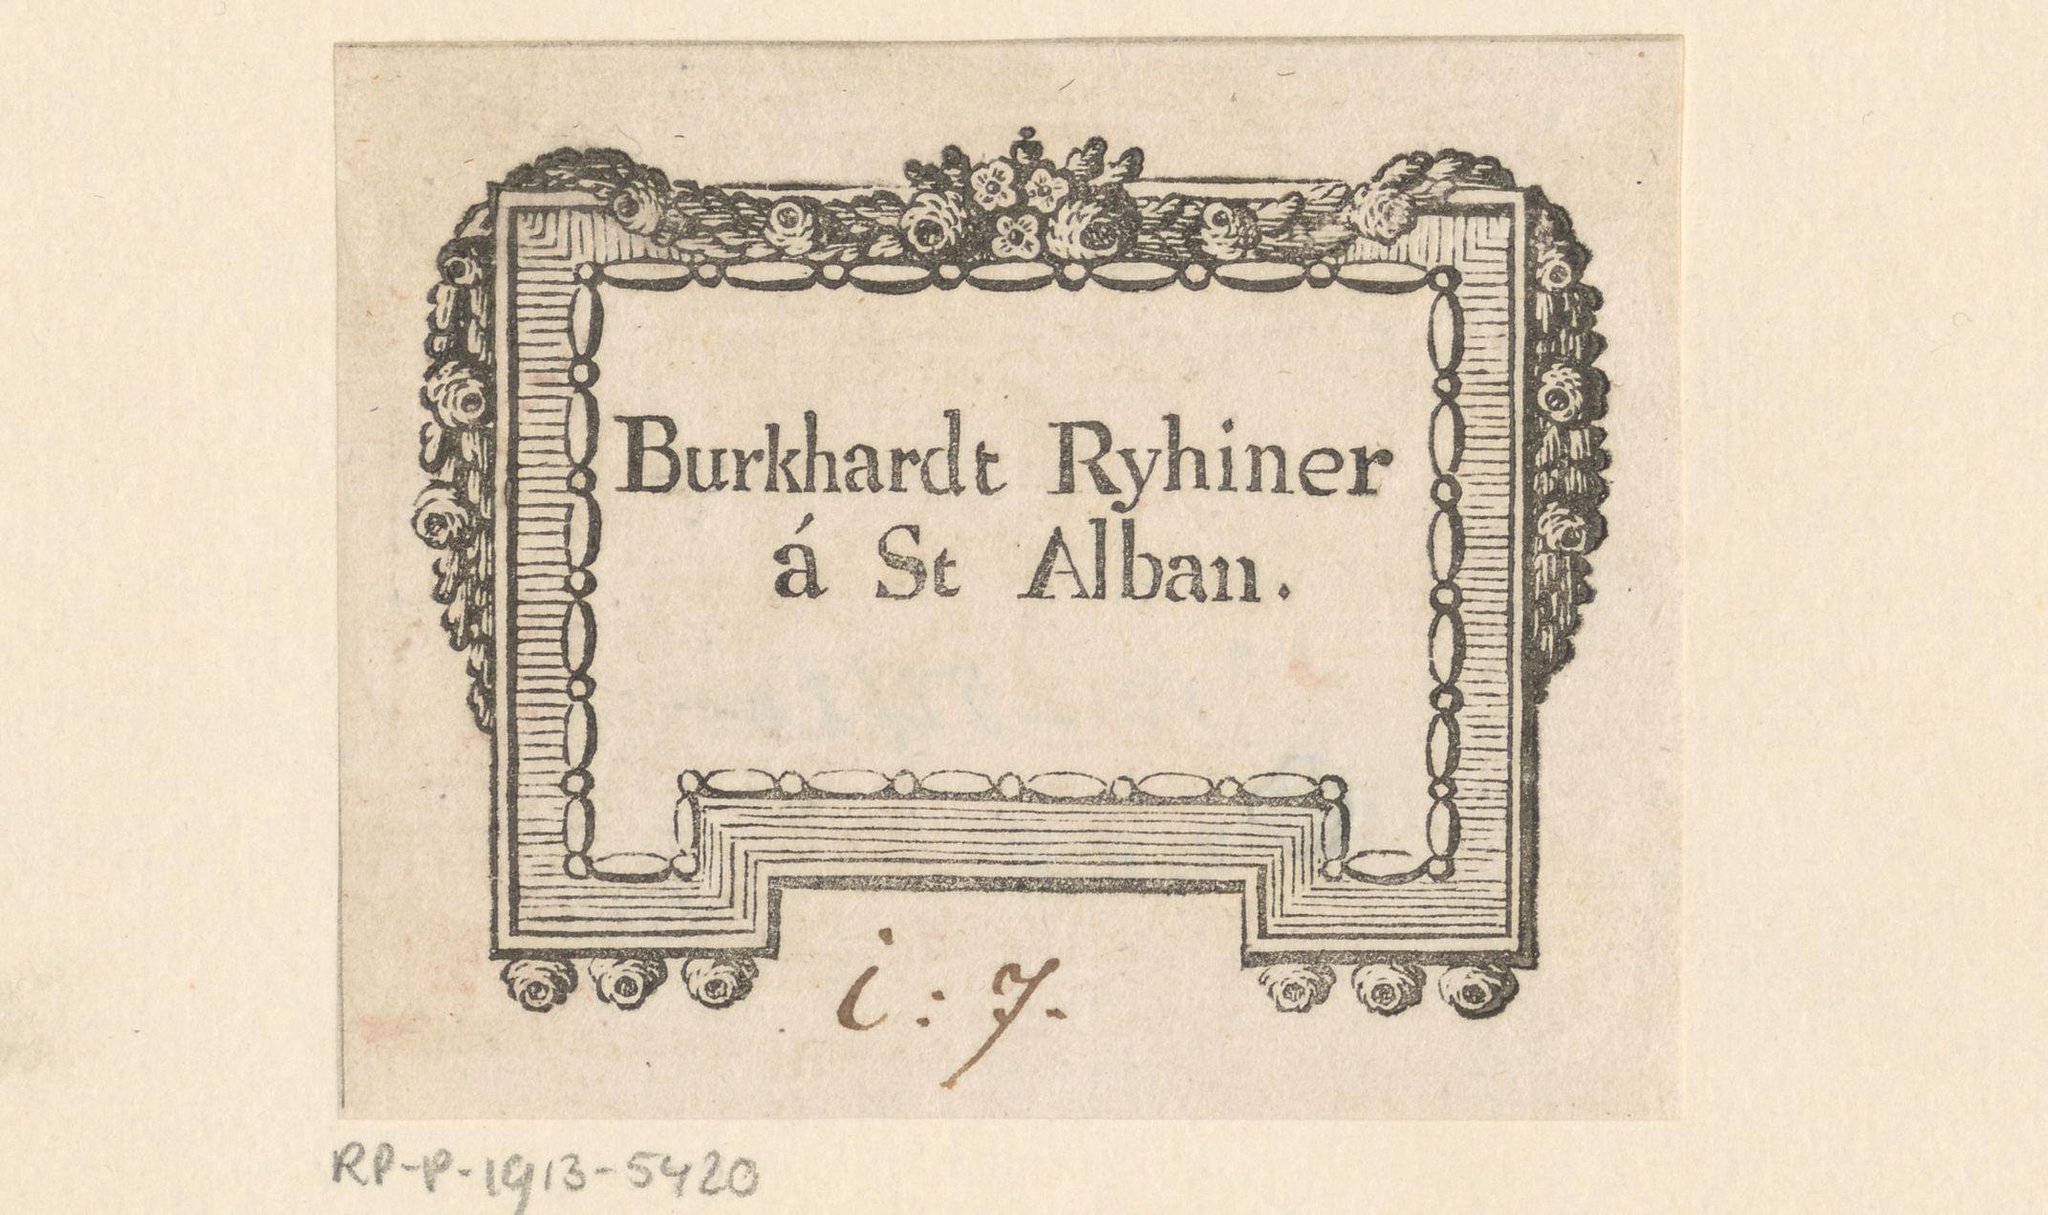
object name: bookplate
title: Ex libris van Burckhardt Ryhiner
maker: Anonymous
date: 1750-1900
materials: paper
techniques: letterpress printing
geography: switzerland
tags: garland, wreath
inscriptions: inscription: ‘i : 7.’, collector's mark: Lugt 2233, collector's mark: Lugt 2760, inscription: ‘Gerster 336’